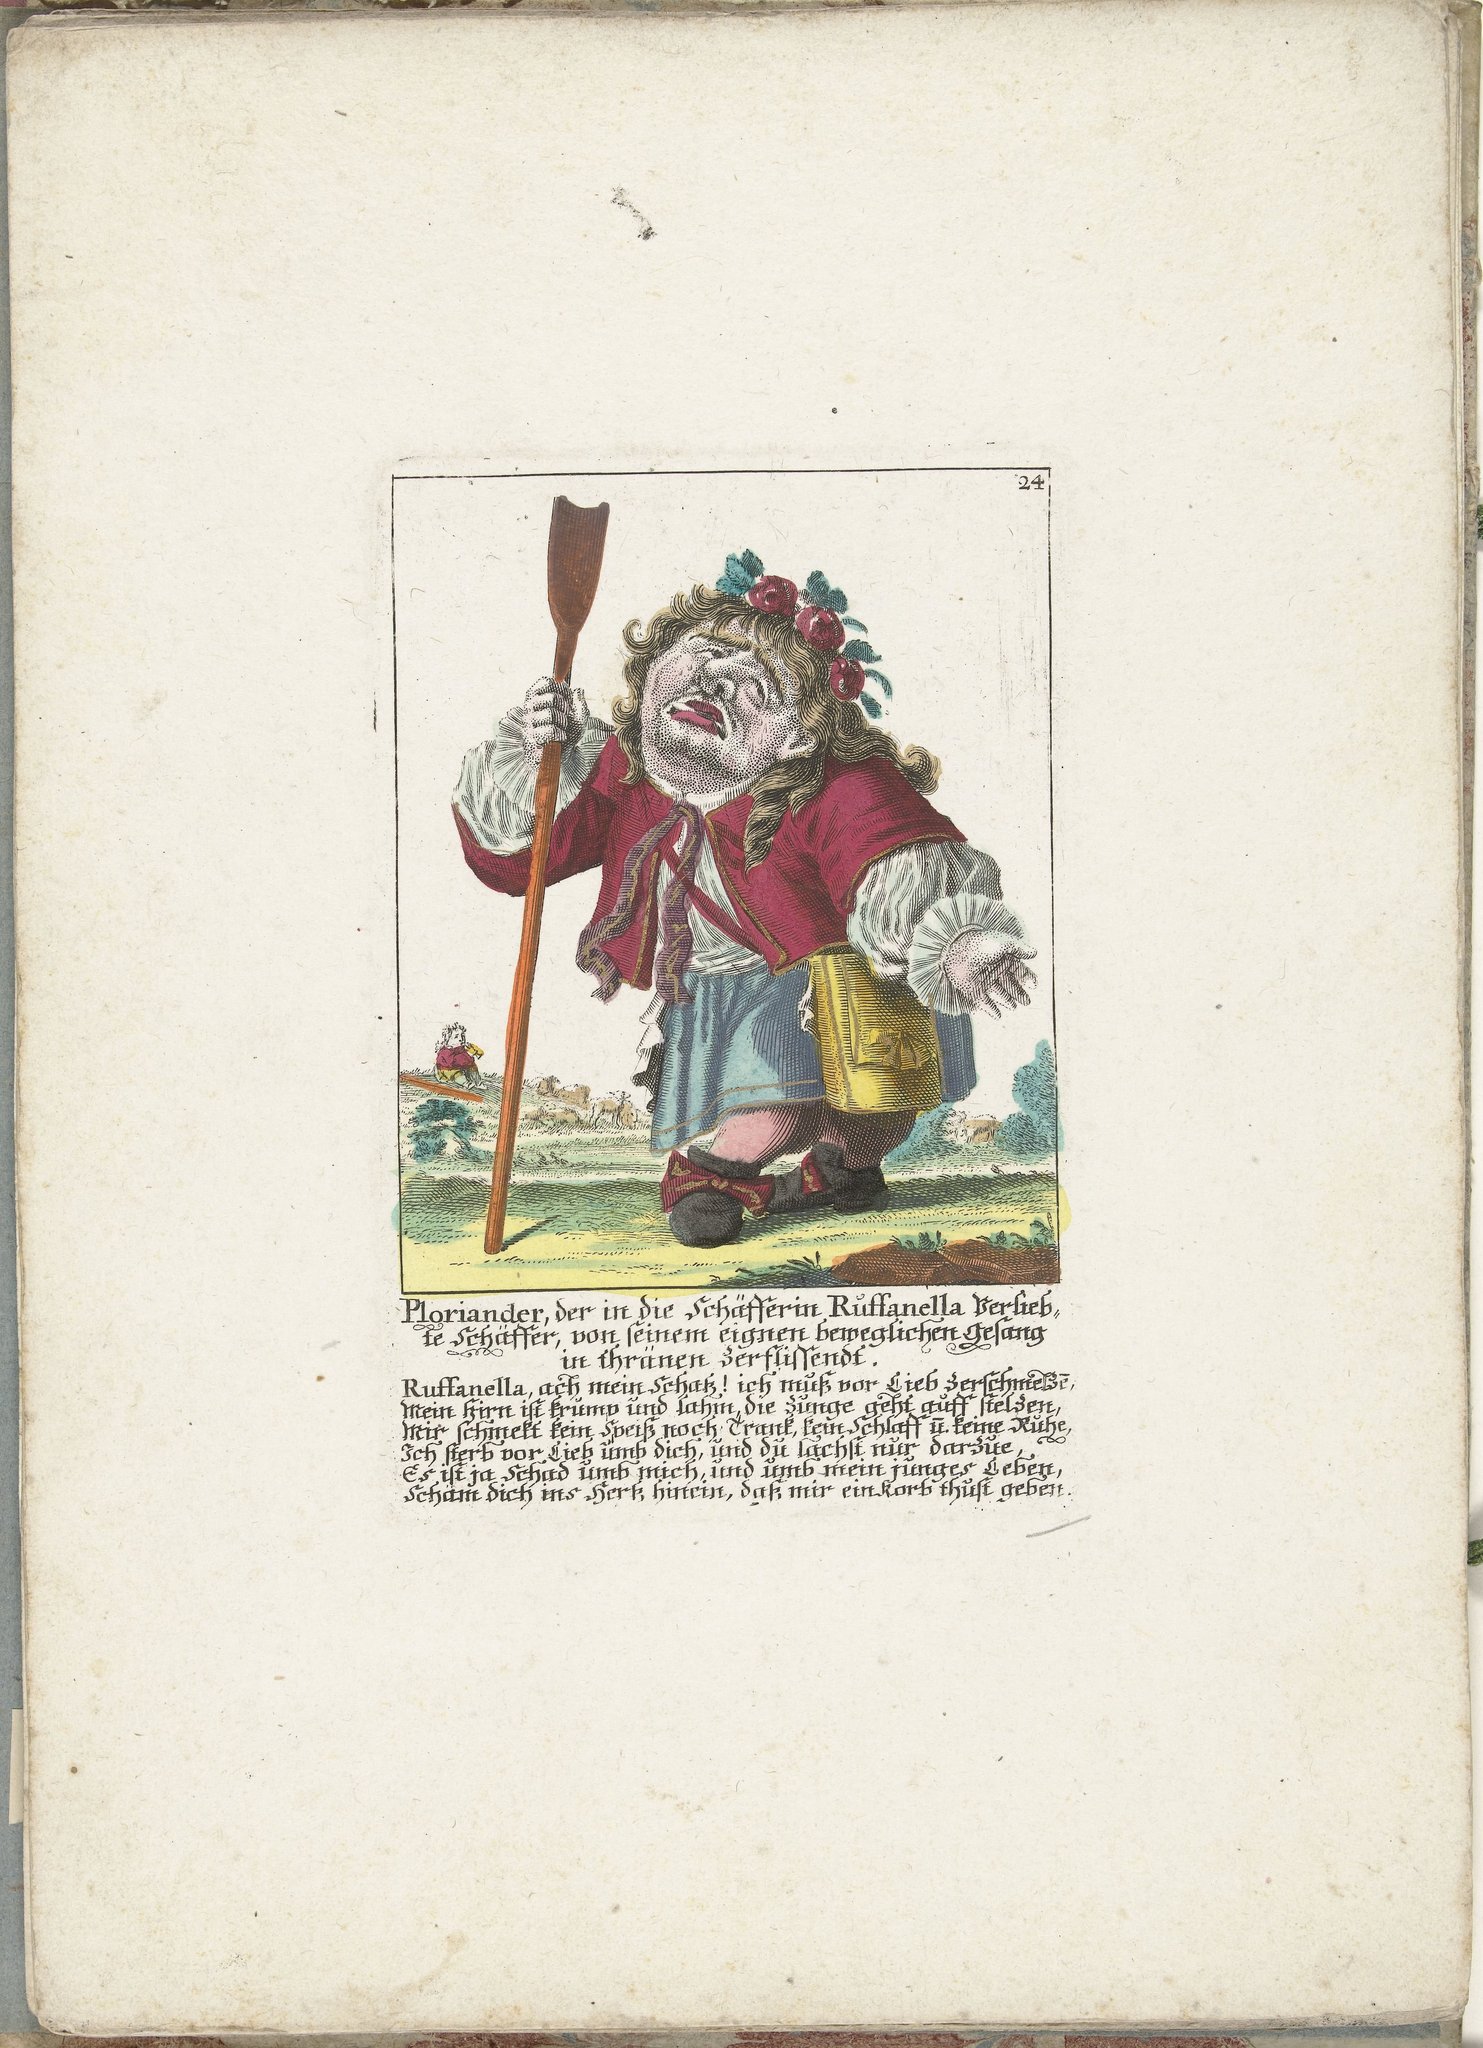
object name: caricature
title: Ploriander, der in die Schäfferin Ruffanella Verliebte Schäffer, von seinem eignen beweglichen gesang in thränen zerflissendt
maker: martin engelbrecht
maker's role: print maker, publisher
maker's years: 1684-1756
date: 1705-1715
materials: paper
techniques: engraving, etching, hand coloring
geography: augsburg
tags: caricatures (human types), herding, herdsman, herdswoman, shepherd, shepherdess, cowherd, etc., little people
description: De kleine mens Ploriander, de herder op wie Ruffanella verliefd is. In het onderschrift onder de titel een zesregelig vers in het Duits. Genummerd rechtsboven: 24. Onderdeel van een losbladige uitgave uit ca. 1710 van een serie karikaturen van kleine mensen, bekend als Het Dwergentooneel.